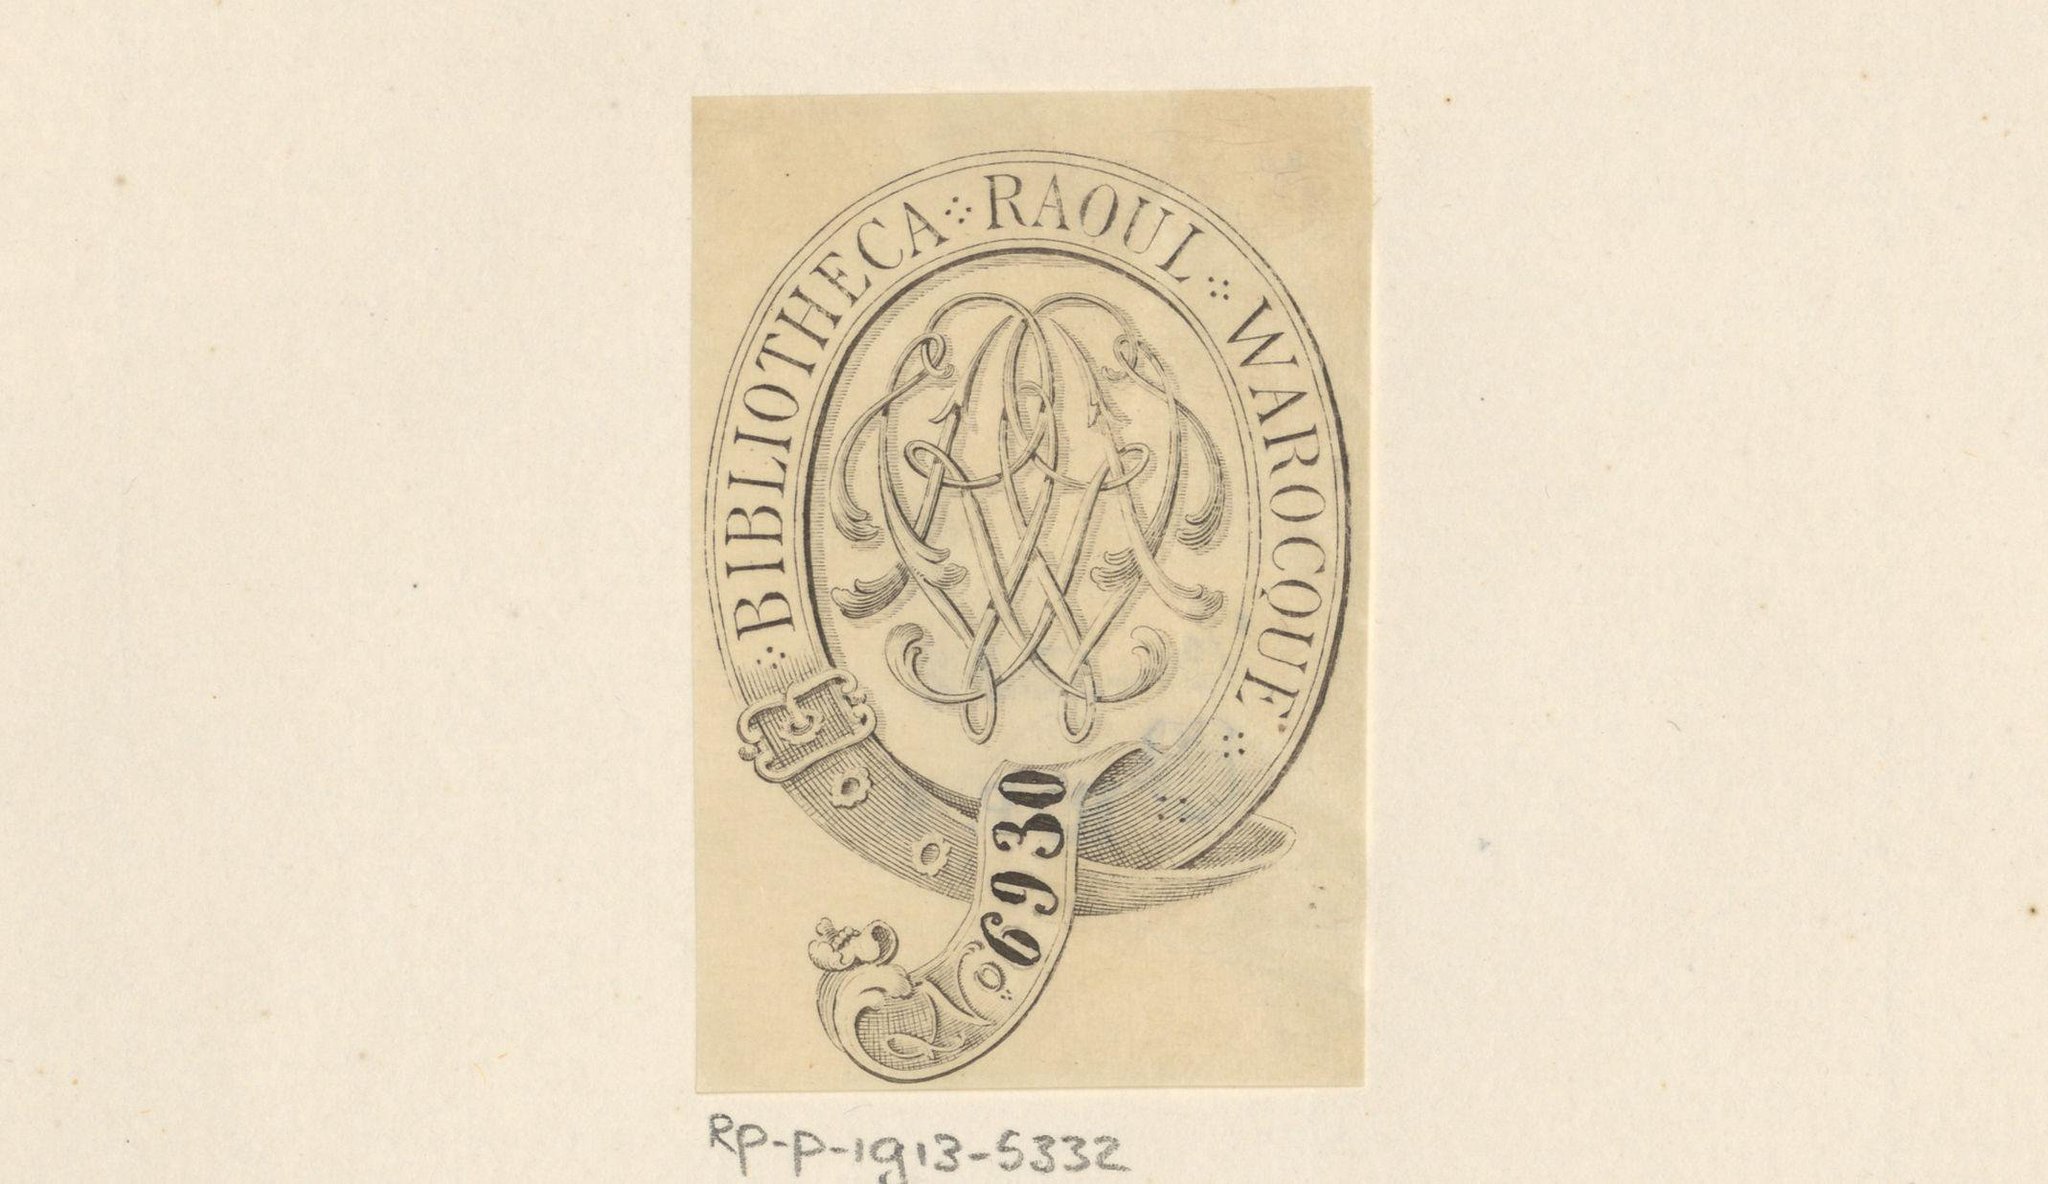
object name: bookplate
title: Ex libris van Bibliotheca Raoul Warocque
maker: Anonymous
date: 1880-1913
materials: paper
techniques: etching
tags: brussels, politician, belt, girdle, waistband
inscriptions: collector's mark: Lugt 2233, number: ‘6930’, collector's mark: Lugt 2760